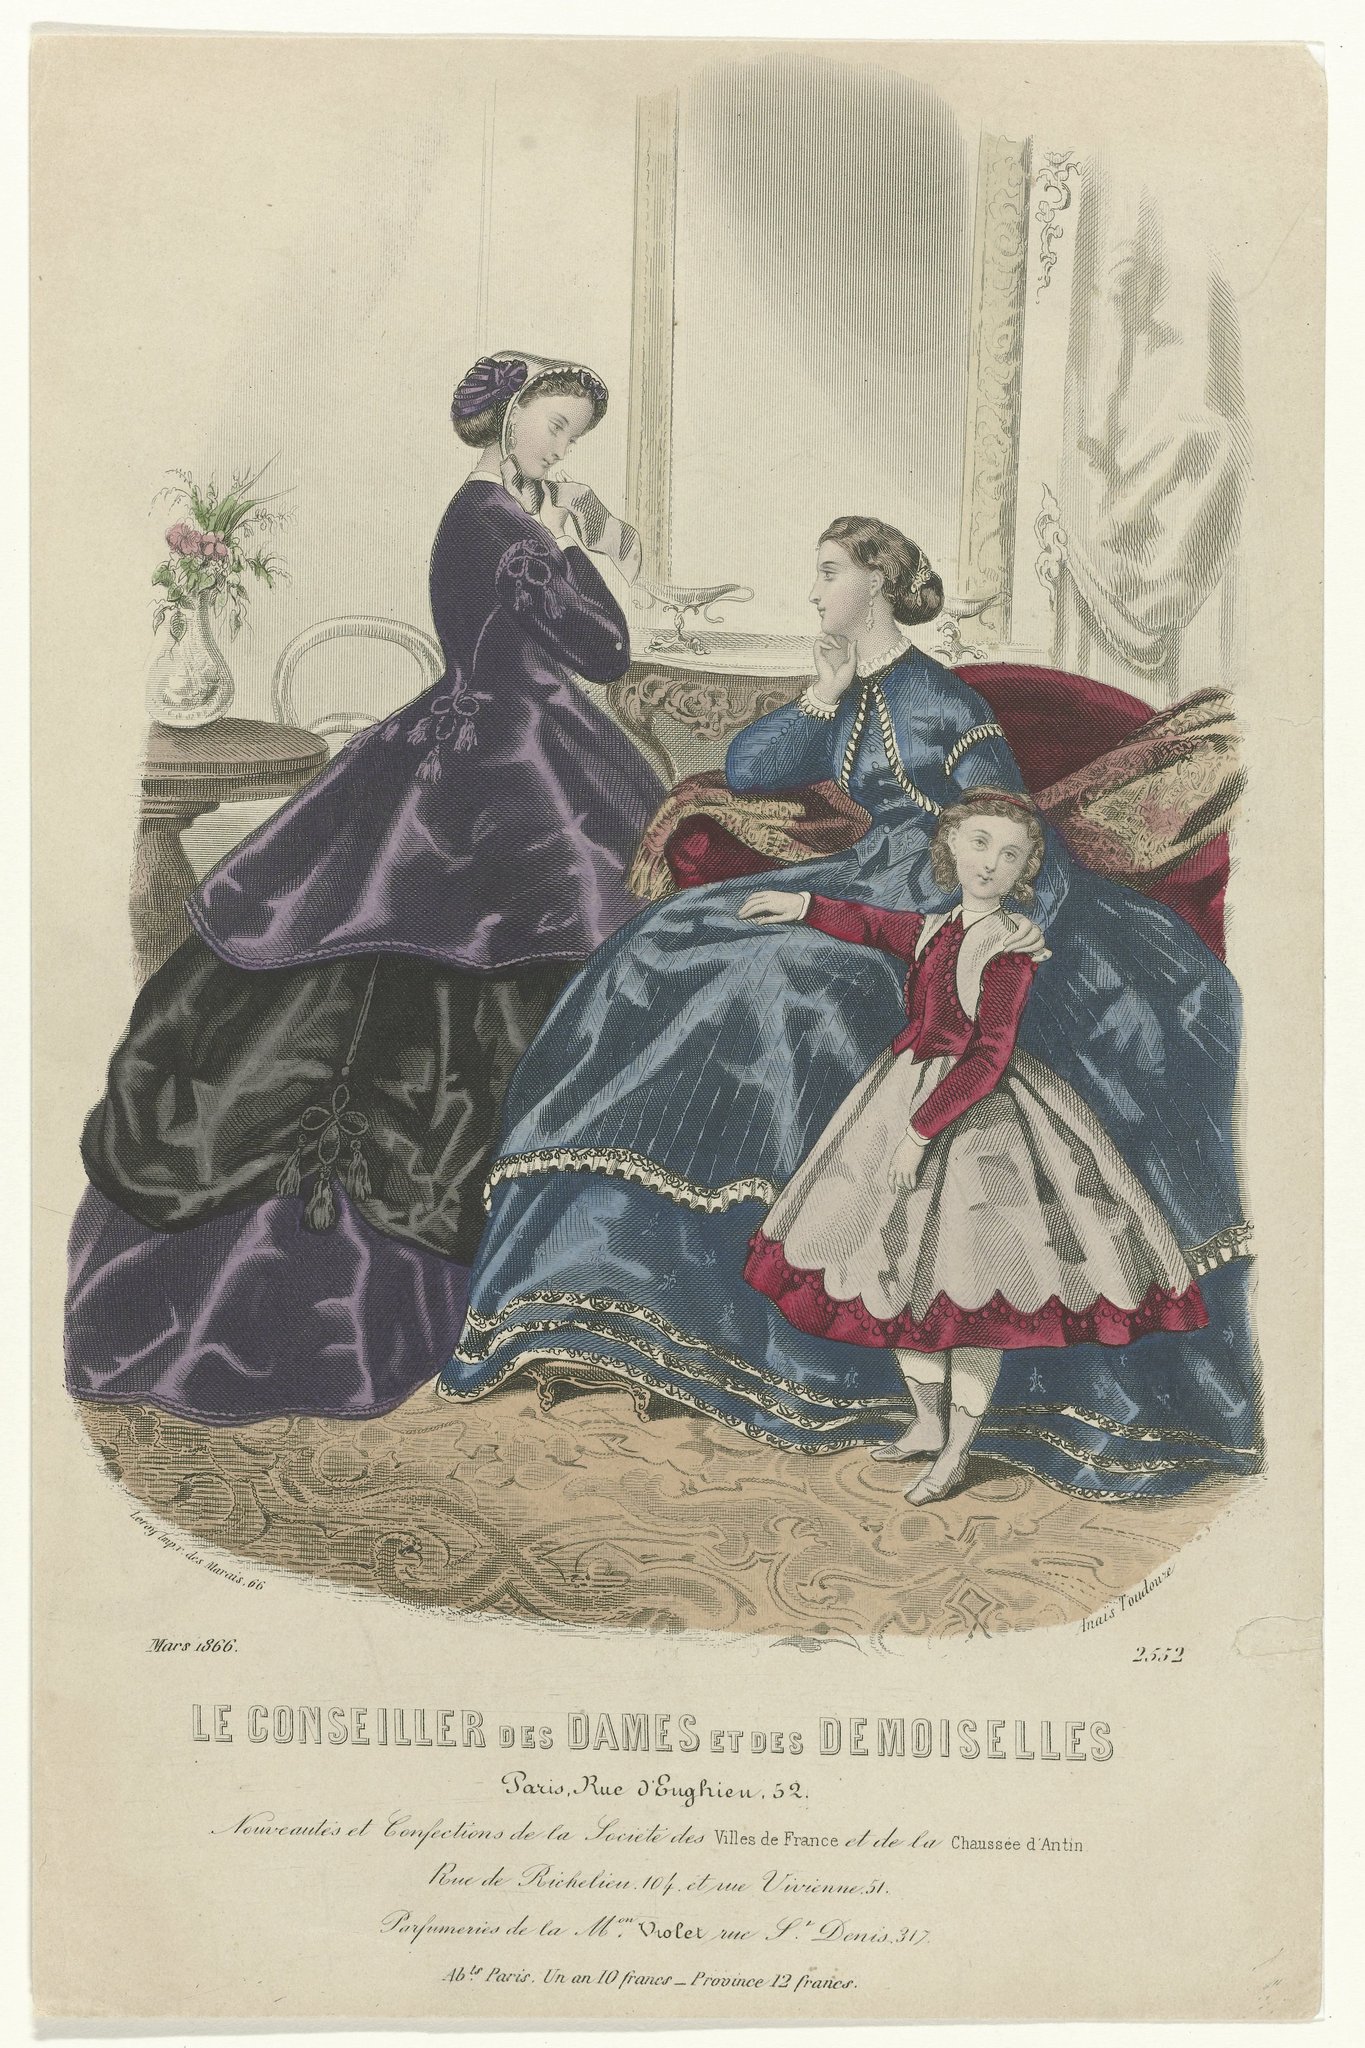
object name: fashion print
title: Le Conseiller des Dames et des Demoiselles, mars 1866, No. 2552 : Nouveautés et Confections (...)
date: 1866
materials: paper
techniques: engraving, hand coloring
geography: paris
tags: clothing for the upper part of the body (+ women's clothes), skirt (+ girls' clothes), diadem, tiara (+ women's clothes), clothing for the upper part of the body (vest) (+ women's clothes), clothing for the upper part of the body (+ girls' clothes), clothing for the upper part of the body (bolero) (+ women's clothes), clothing for the upper part of the body (bolero) (+ girls' clothes), fashion plates, head-gear: hat (+ women's clothes), skirt (+ women's clothes)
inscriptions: caption: ‘Nouveautés et Confections de la Société des Villes de France et de la Chaussée d'Antin Rue de Richelieu 104 et rue Vivienne 51. Parfumeries de la Mon. Violet rue St. denis 317.’, inscription: ‘Ab.ts Paris, Un an, 10 francs. _Province, 12 francs.’, title: ‘LE CONSEILLER DES DAMES ET DES DEMOISELLES’, address: ‘Paris, Rue d'Eughieu, 52.’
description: Twee vrouwen en een kind in interieur. Eén van hen strikt de linten van haar hoed. Zij draagt een jas en een rok die versierd zijn met brandebourgs en kwasten. Een andere vrouw zit op een bank, gekleed in een gestreept ensemble bestaande uit een hesje,vest en rok. Naast haar een meisje in eenzelfde soort ensemble. Onder de voorstelling enkele regels reclametekst voor verschillende producten. Prent uit het modetijdschrift Le Conseiller des Dames (1847-1892).